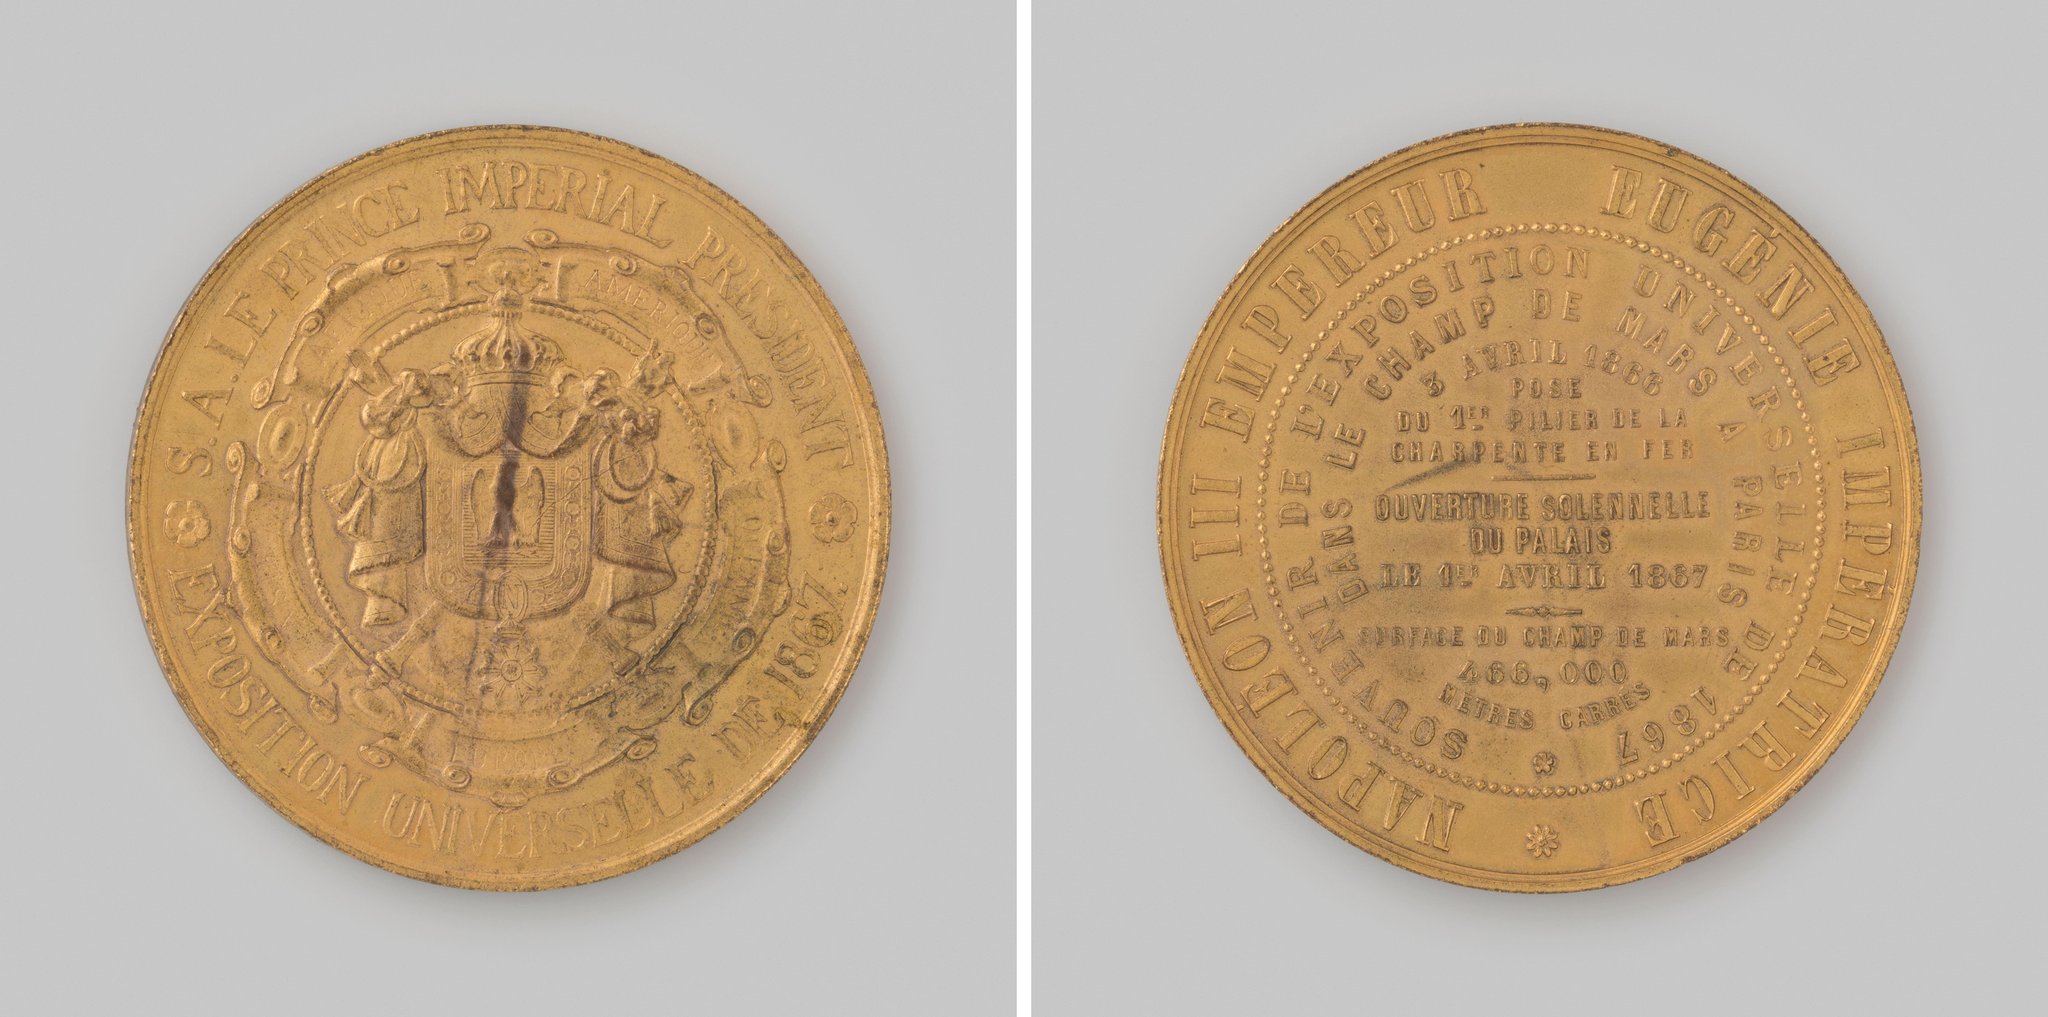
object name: history medal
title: Aandenken aan de Wereldtentoonstelling te Parijs 1867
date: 1867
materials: brass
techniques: striking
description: Vergulde penning, op de voorzijde het Franse wapenschild op gekruiste scepters op een gekroonde mantel, waarbuiten een rand met vijf banderols met de namen van werelddelen, met omschrift, op de keerzijde elf regels tekst met dubbel omschrift, waarbuiten een parelcirkel en een omschrift